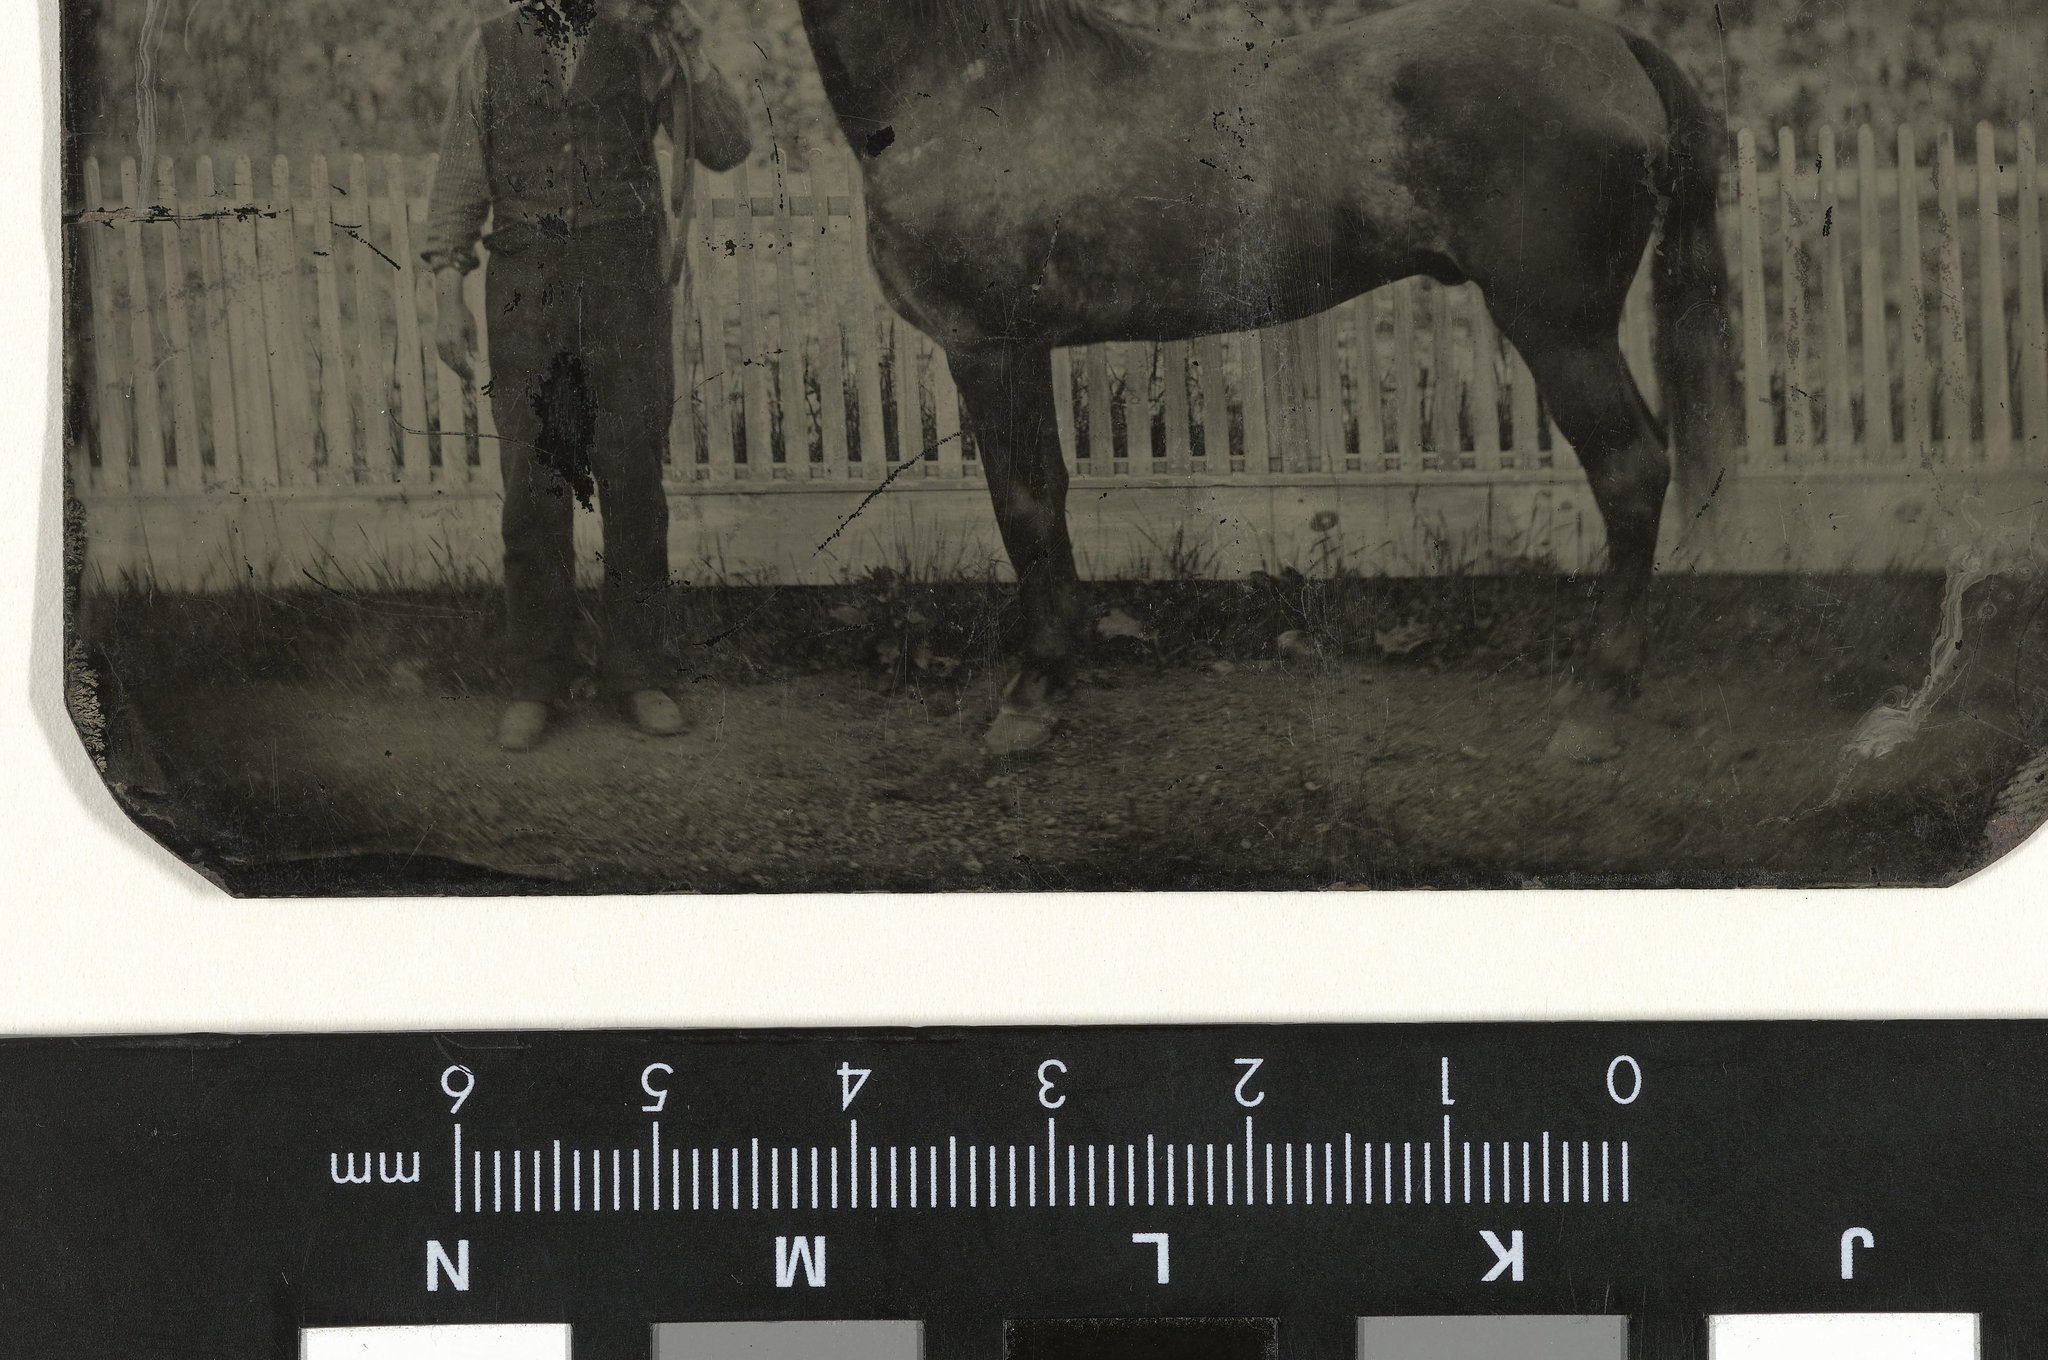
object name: photograph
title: Man en paard (het gezicht van de man is weggekrast)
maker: Anonymous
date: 1860-1900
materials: metal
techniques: ferrotyping